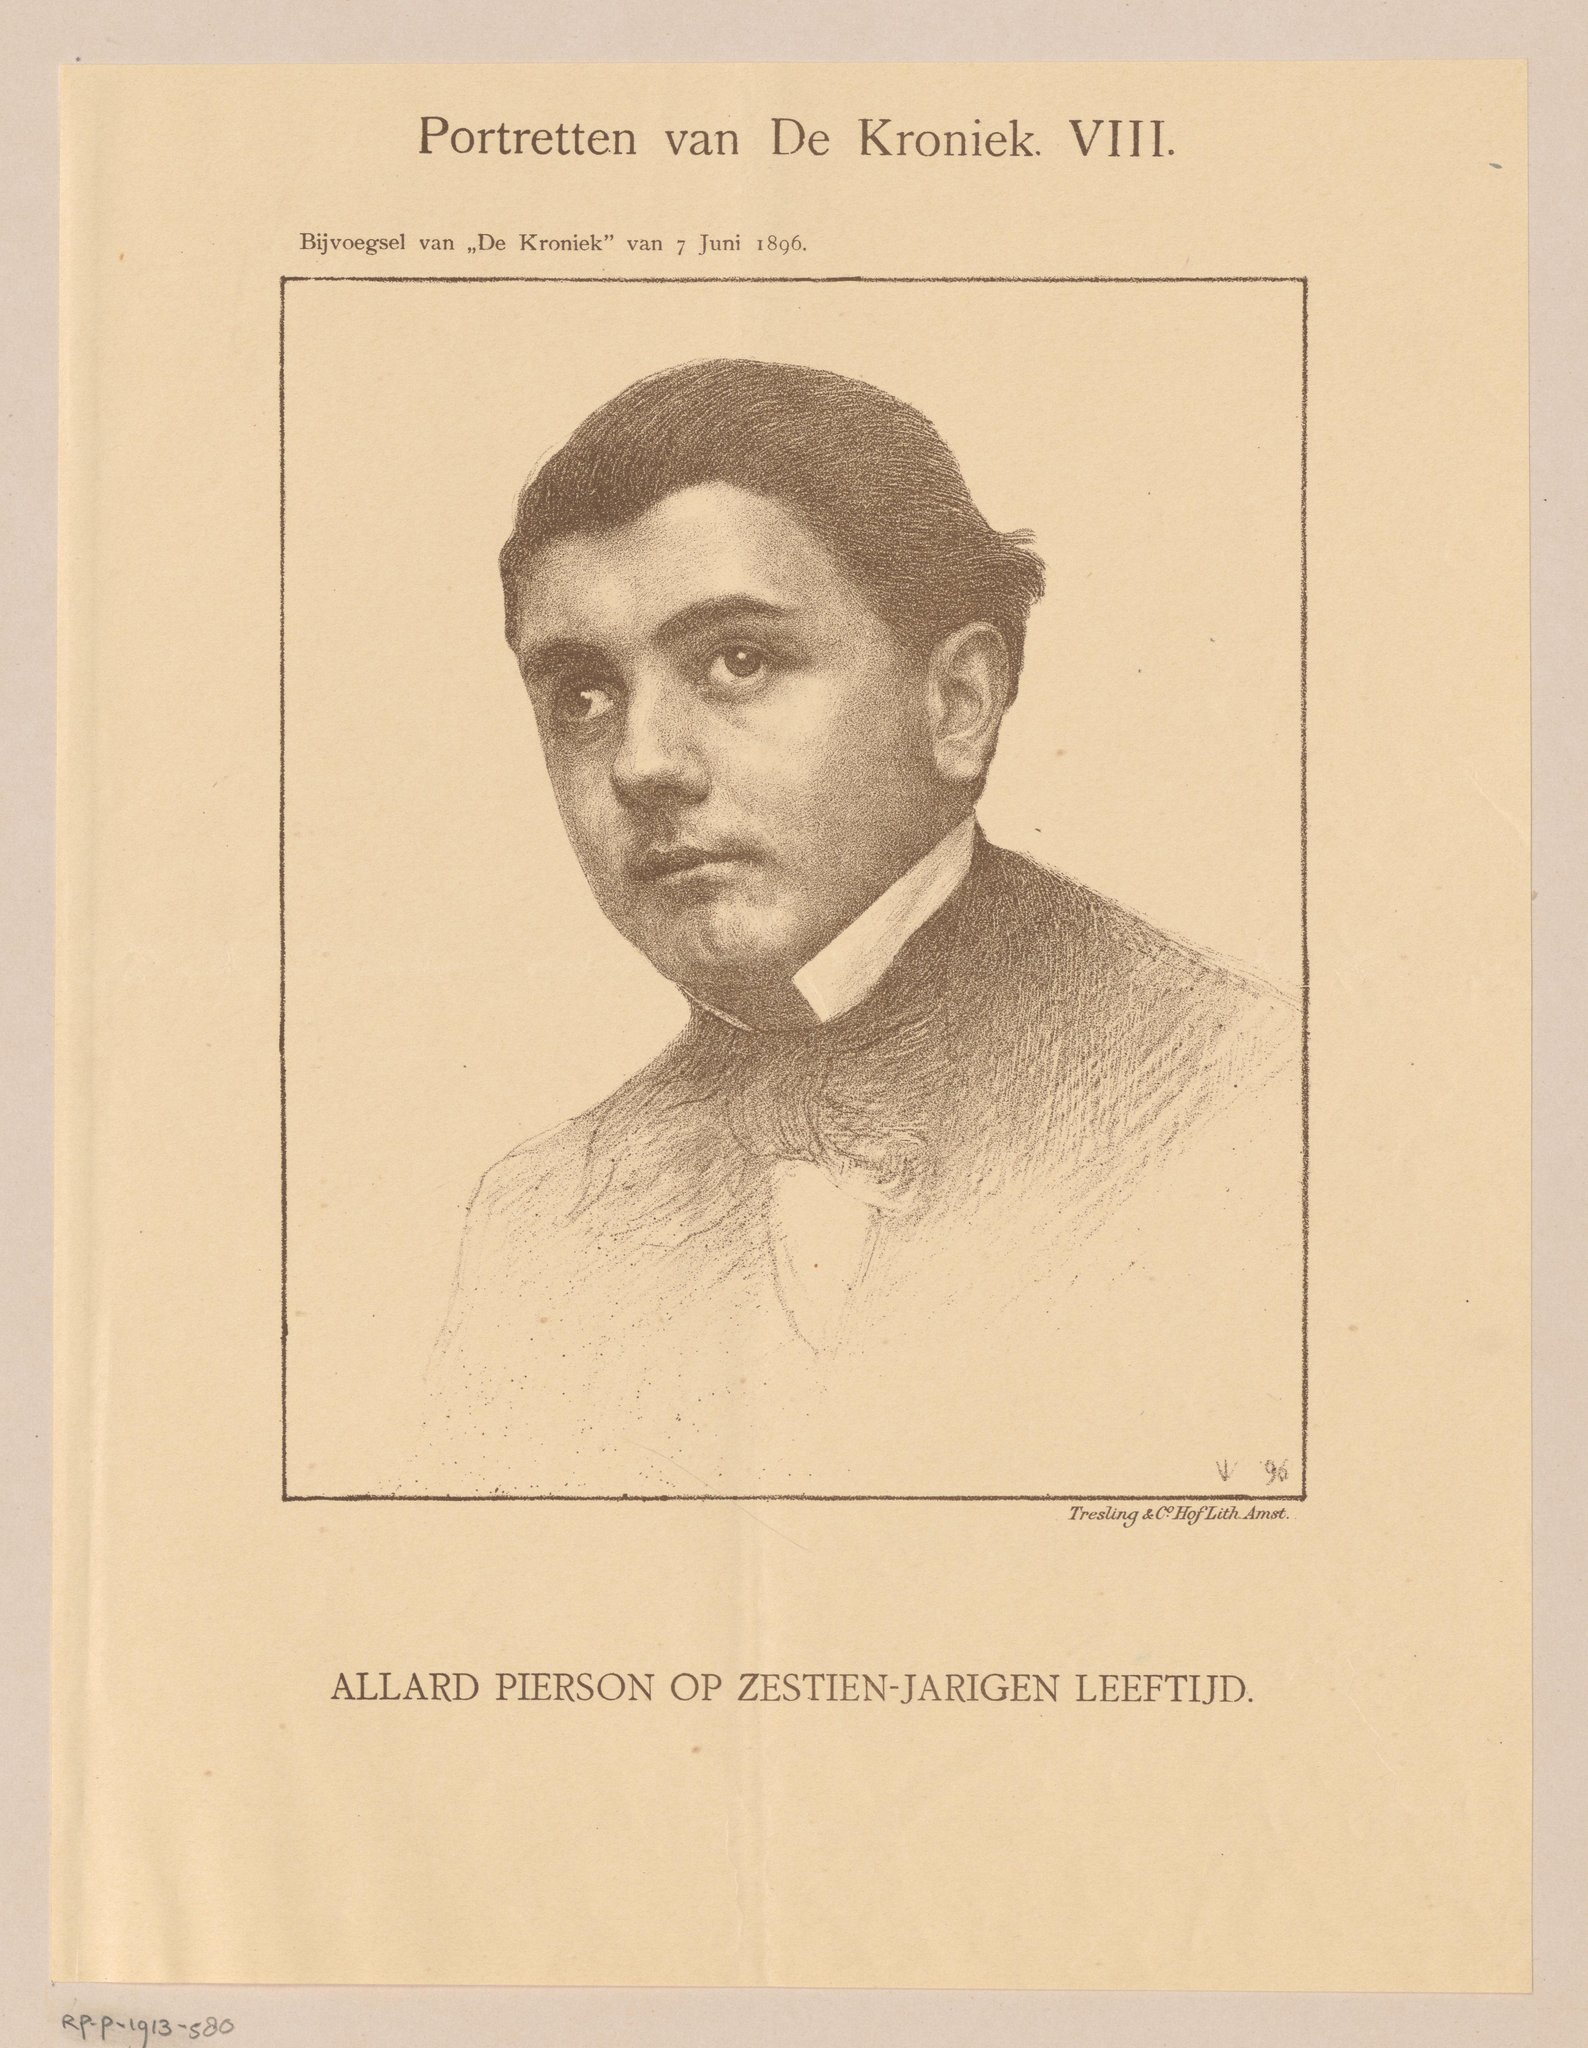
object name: print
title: Portretten van De Kroniek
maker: jan veth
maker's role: designer, draughtsman, painter, print maker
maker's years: 1864-1925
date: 1896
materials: paper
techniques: lithograph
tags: amsterdam, allard pierson, historical persons, youth, adolescent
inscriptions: collector's mark: Lugt 2233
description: Dit portret werd uitgegeven als bijvoegsel bij De Kroniek op 7 juni 1896.